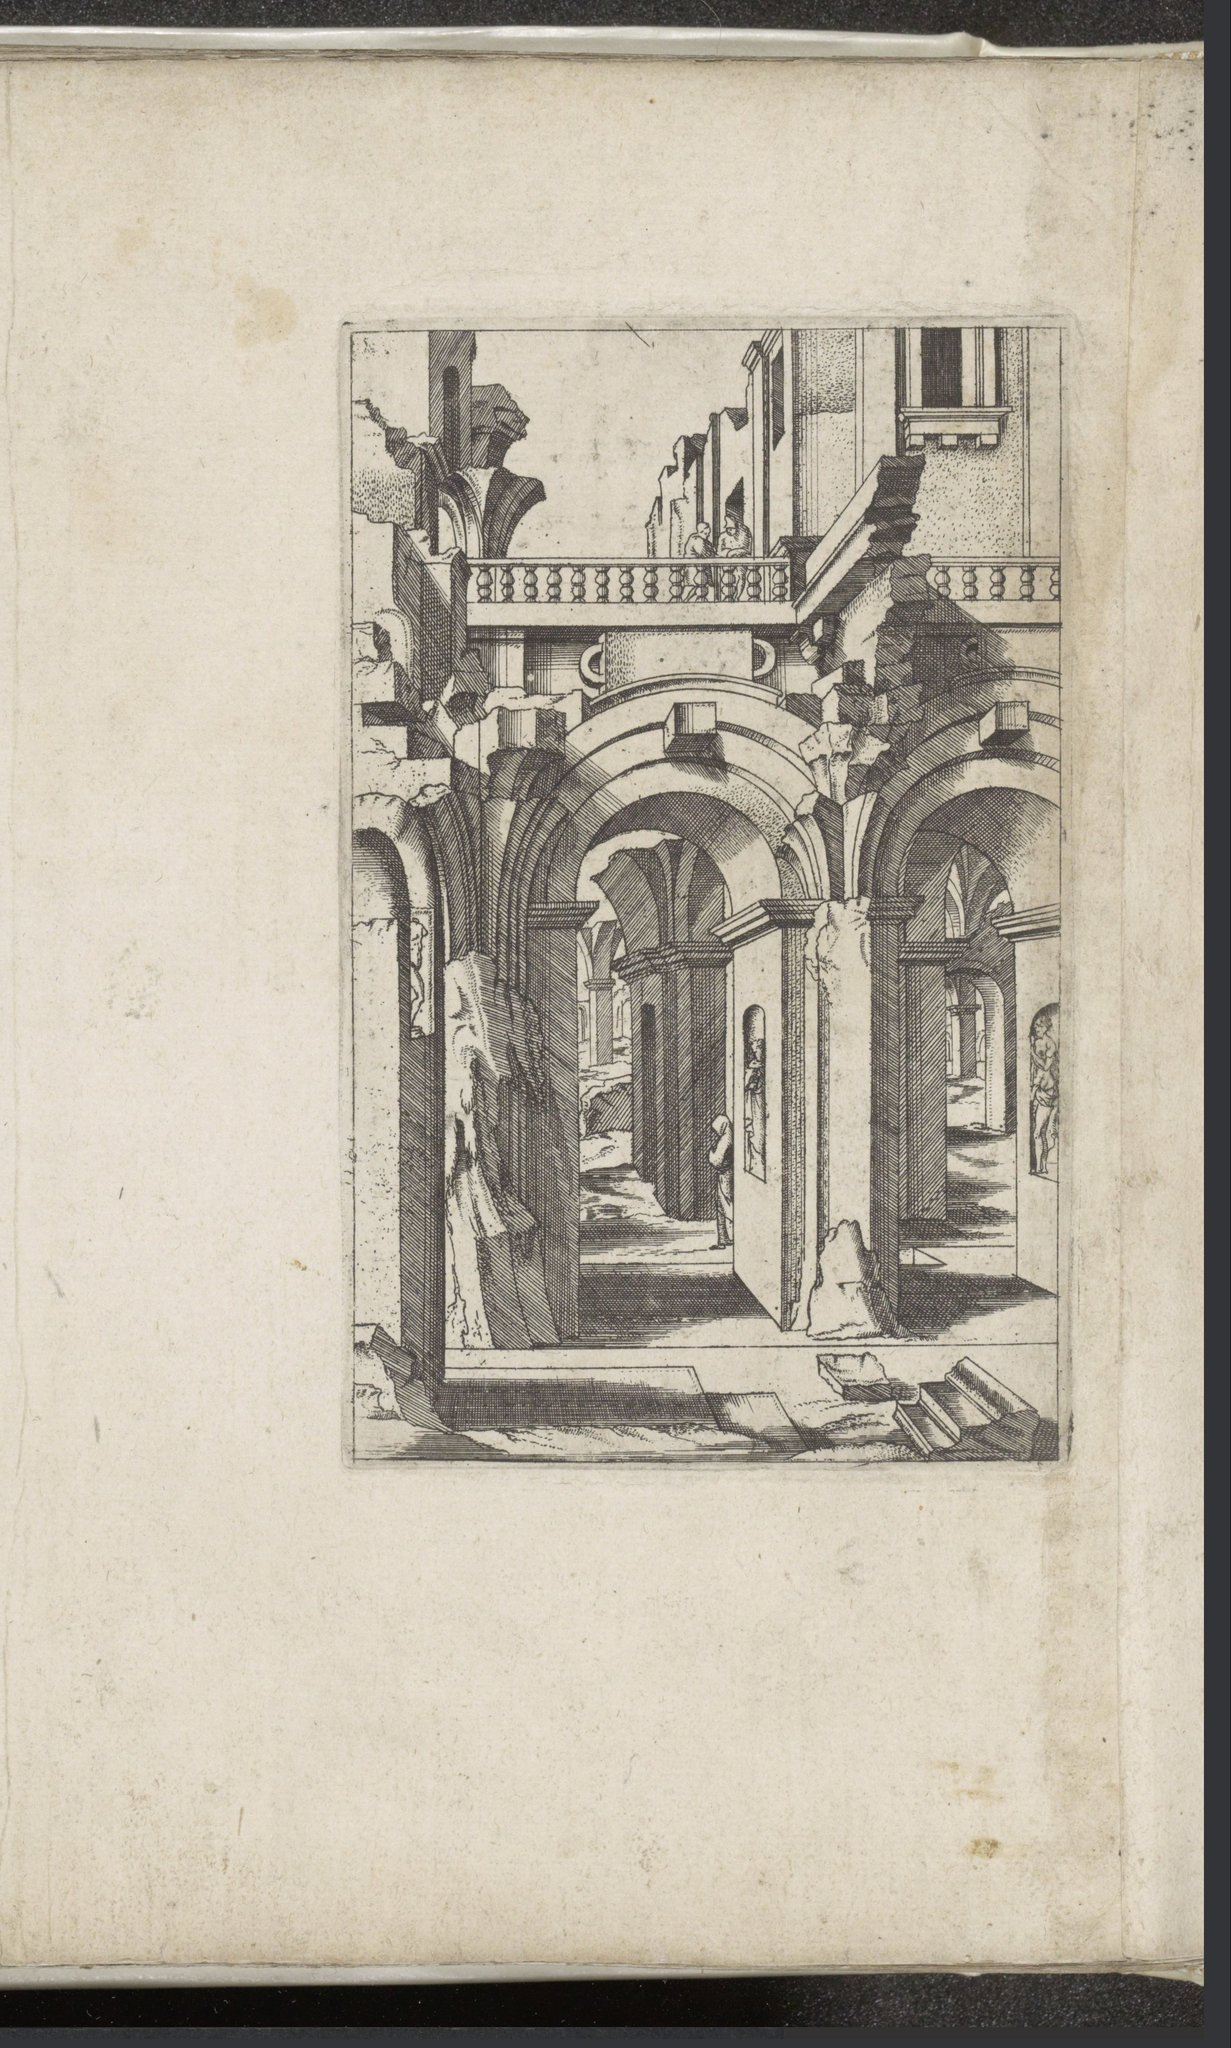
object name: album leaf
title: Cum Nactus Essem Duodecim Fragmenta Structurae veteris (...)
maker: Anonymous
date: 1550-1575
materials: paper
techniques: etching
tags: ruin of a building ~ architecture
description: Overblijfselen van een meerbeukig gebouw. Op de eerste verdieping leunen twee mannen over de balustrade. Deze prent maakt deel uit van een album.